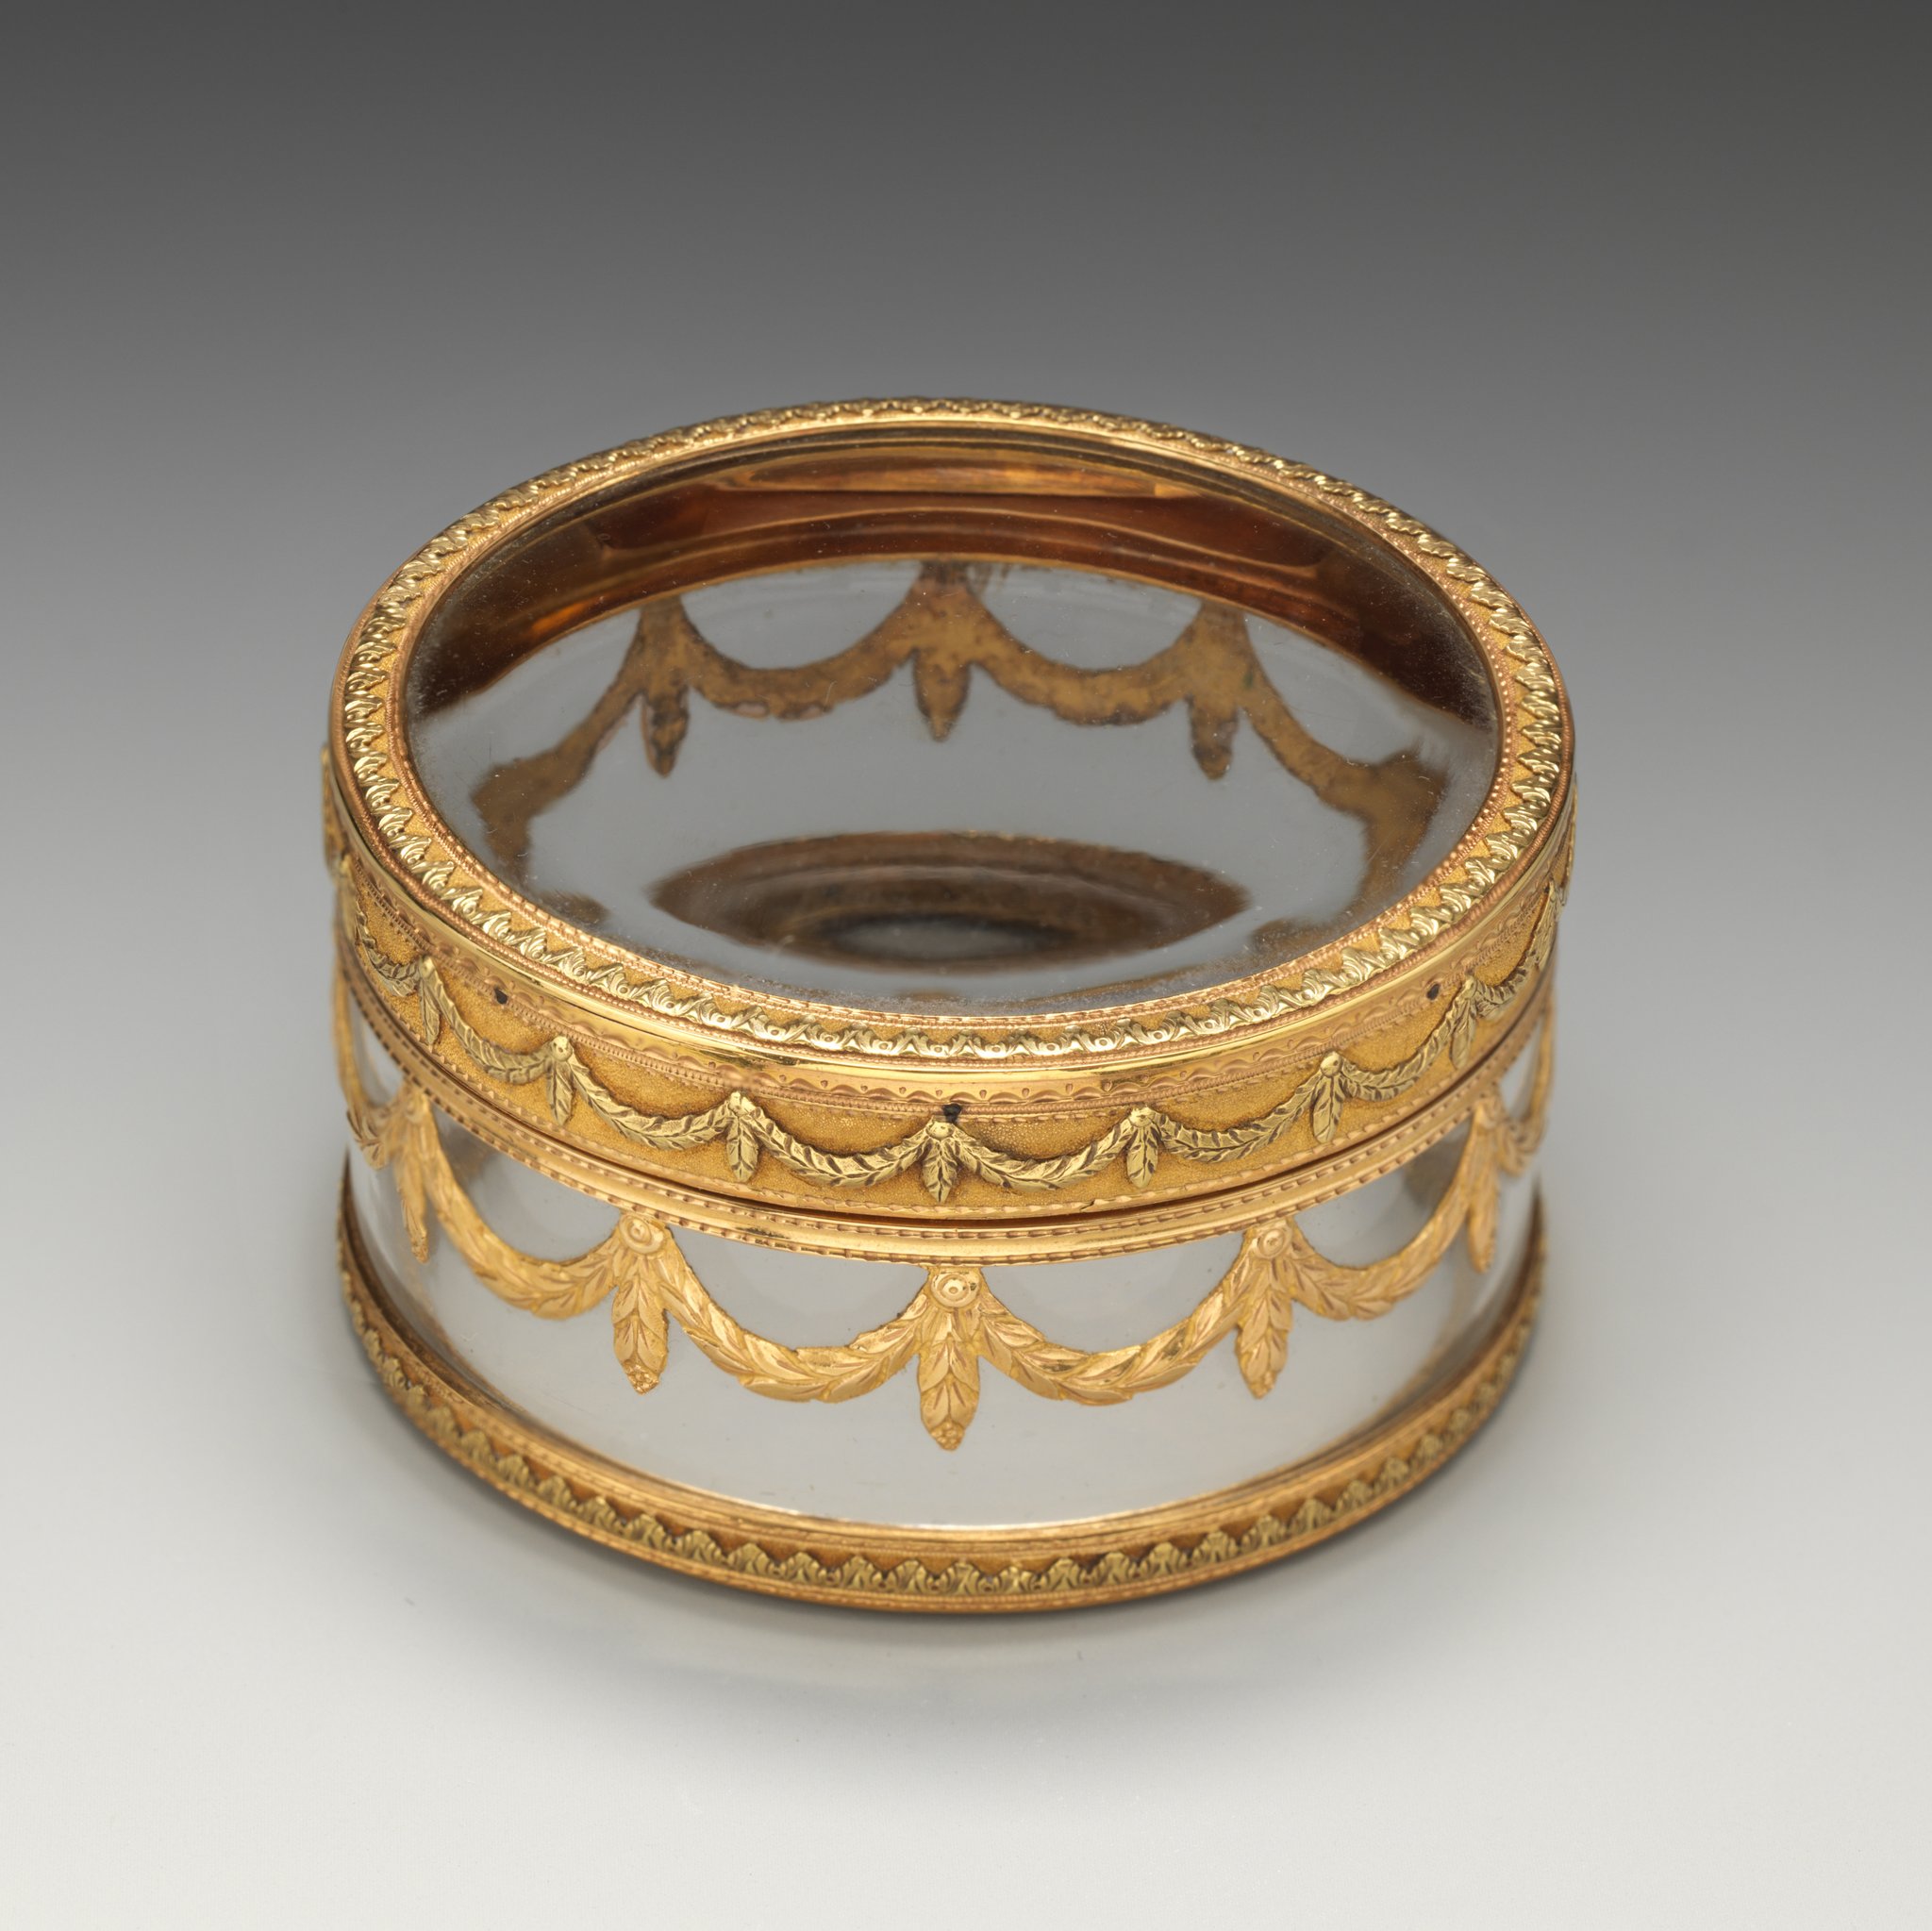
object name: box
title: Circular box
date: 1780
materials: gold, quartz